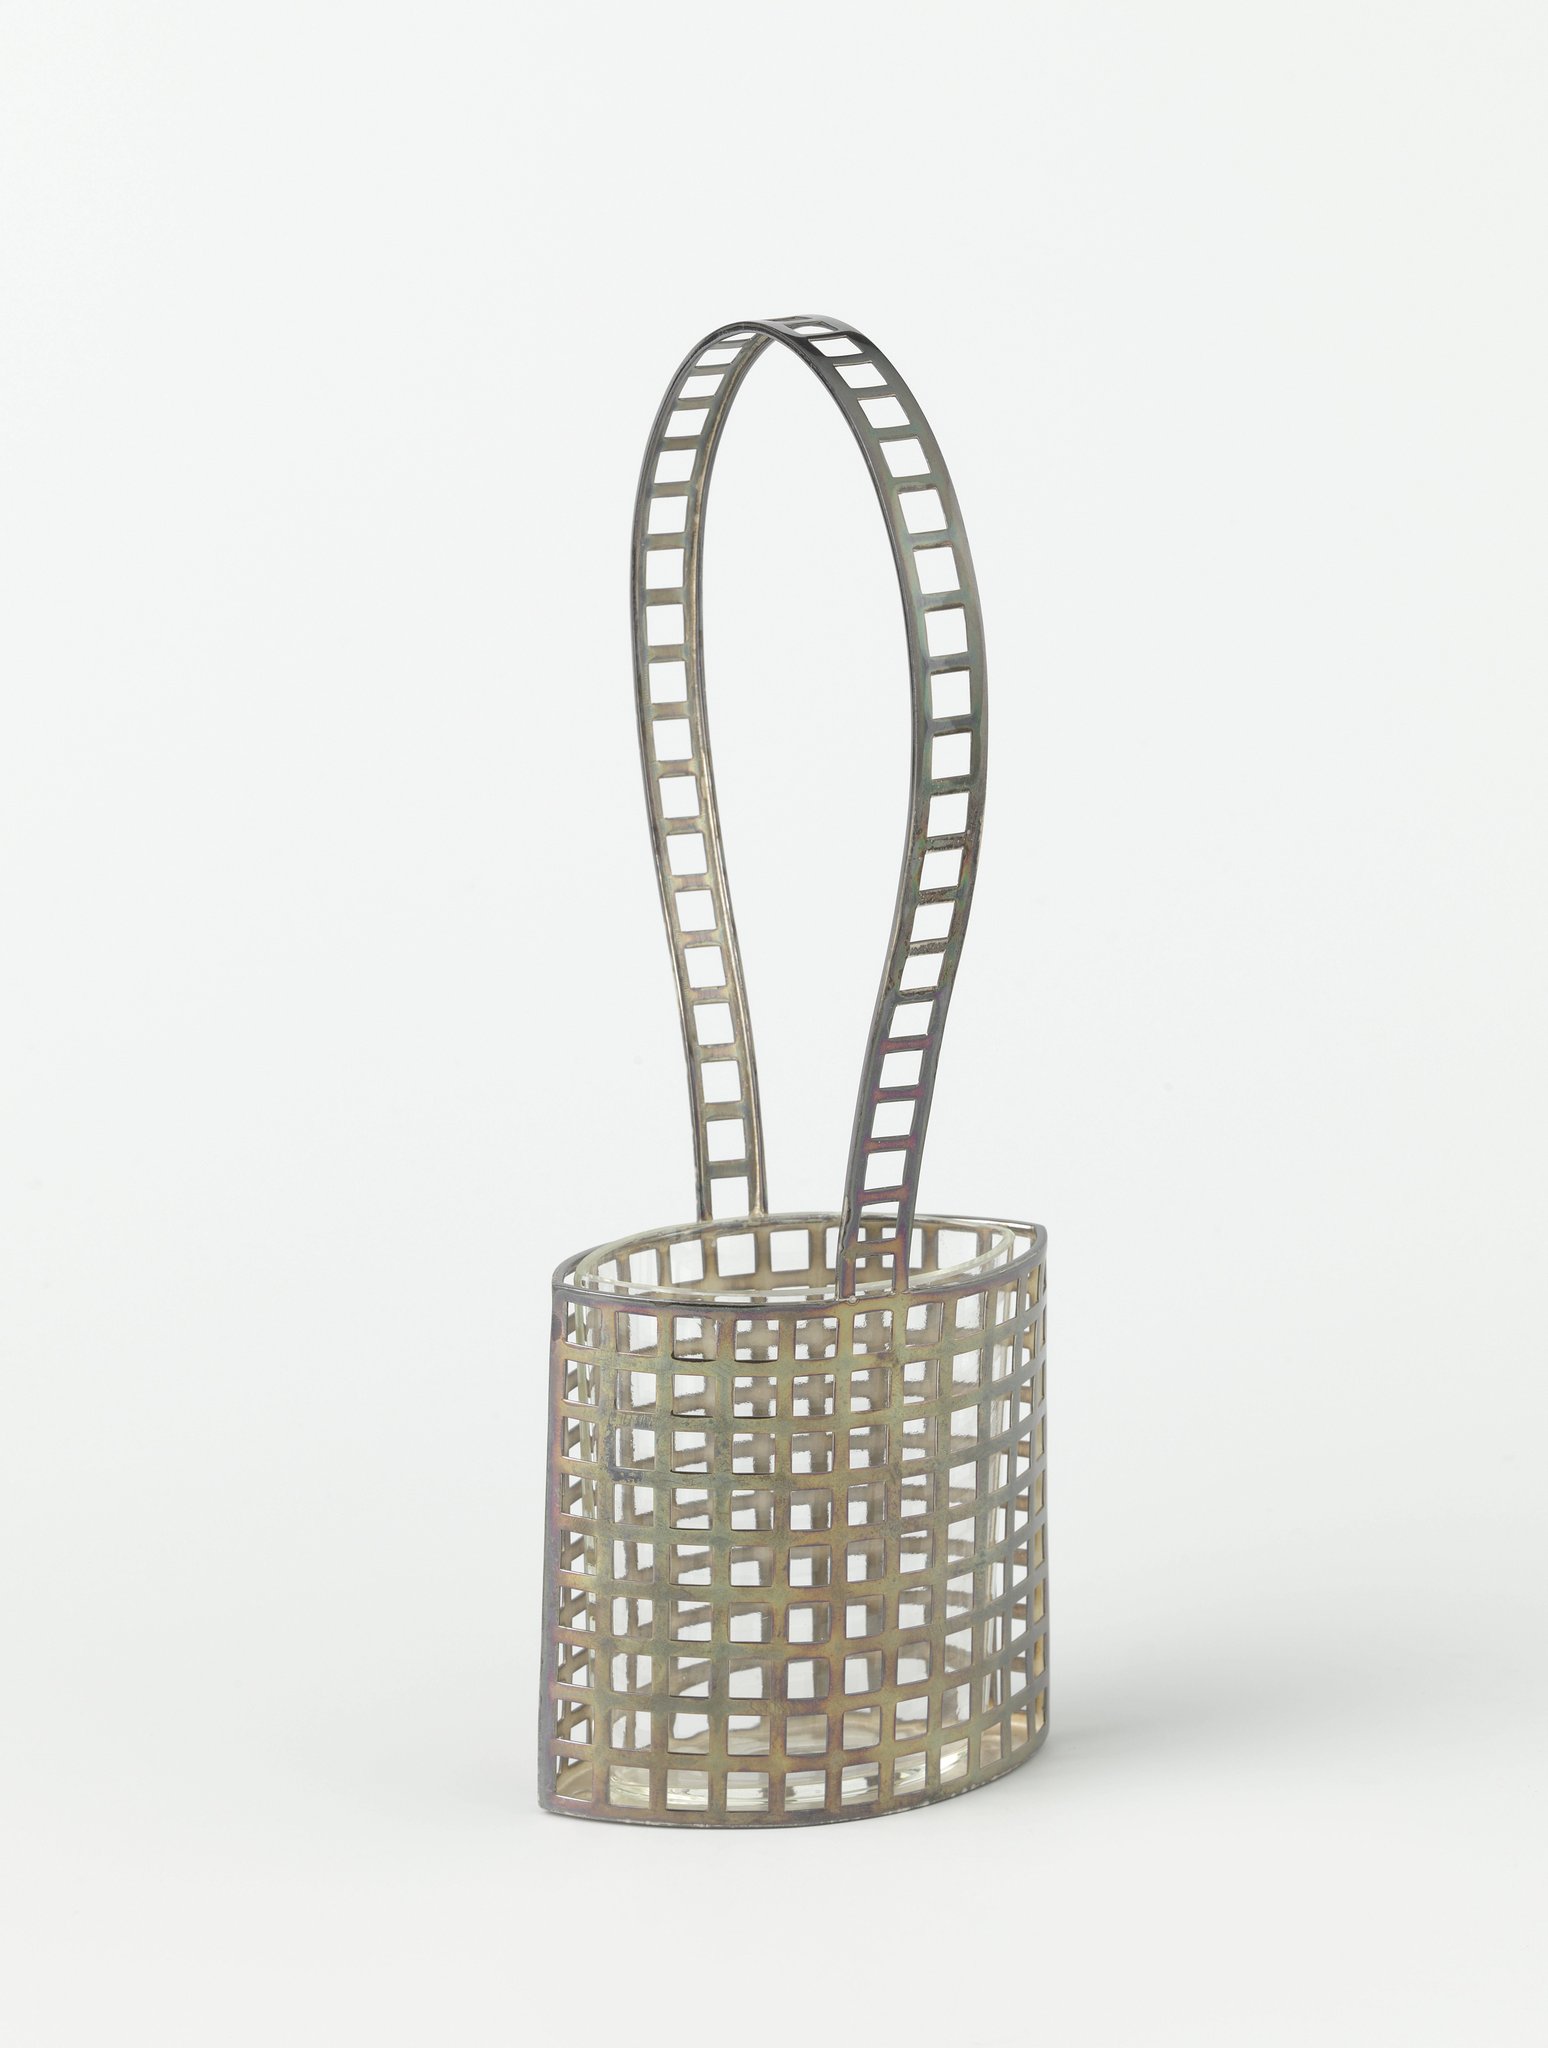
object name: ring basket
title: Basket with Handle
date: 1905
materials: glass, silver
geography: vienna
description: Spitsovale hengselmand van zilver, met binnenbak van kleurloos glas. De rechtwandige mand heeft een lusvormig hengsel. Zowel de wanden van de mand als het hengsel zijn geheel opgengewerkt met een patroon van vierkantjes.